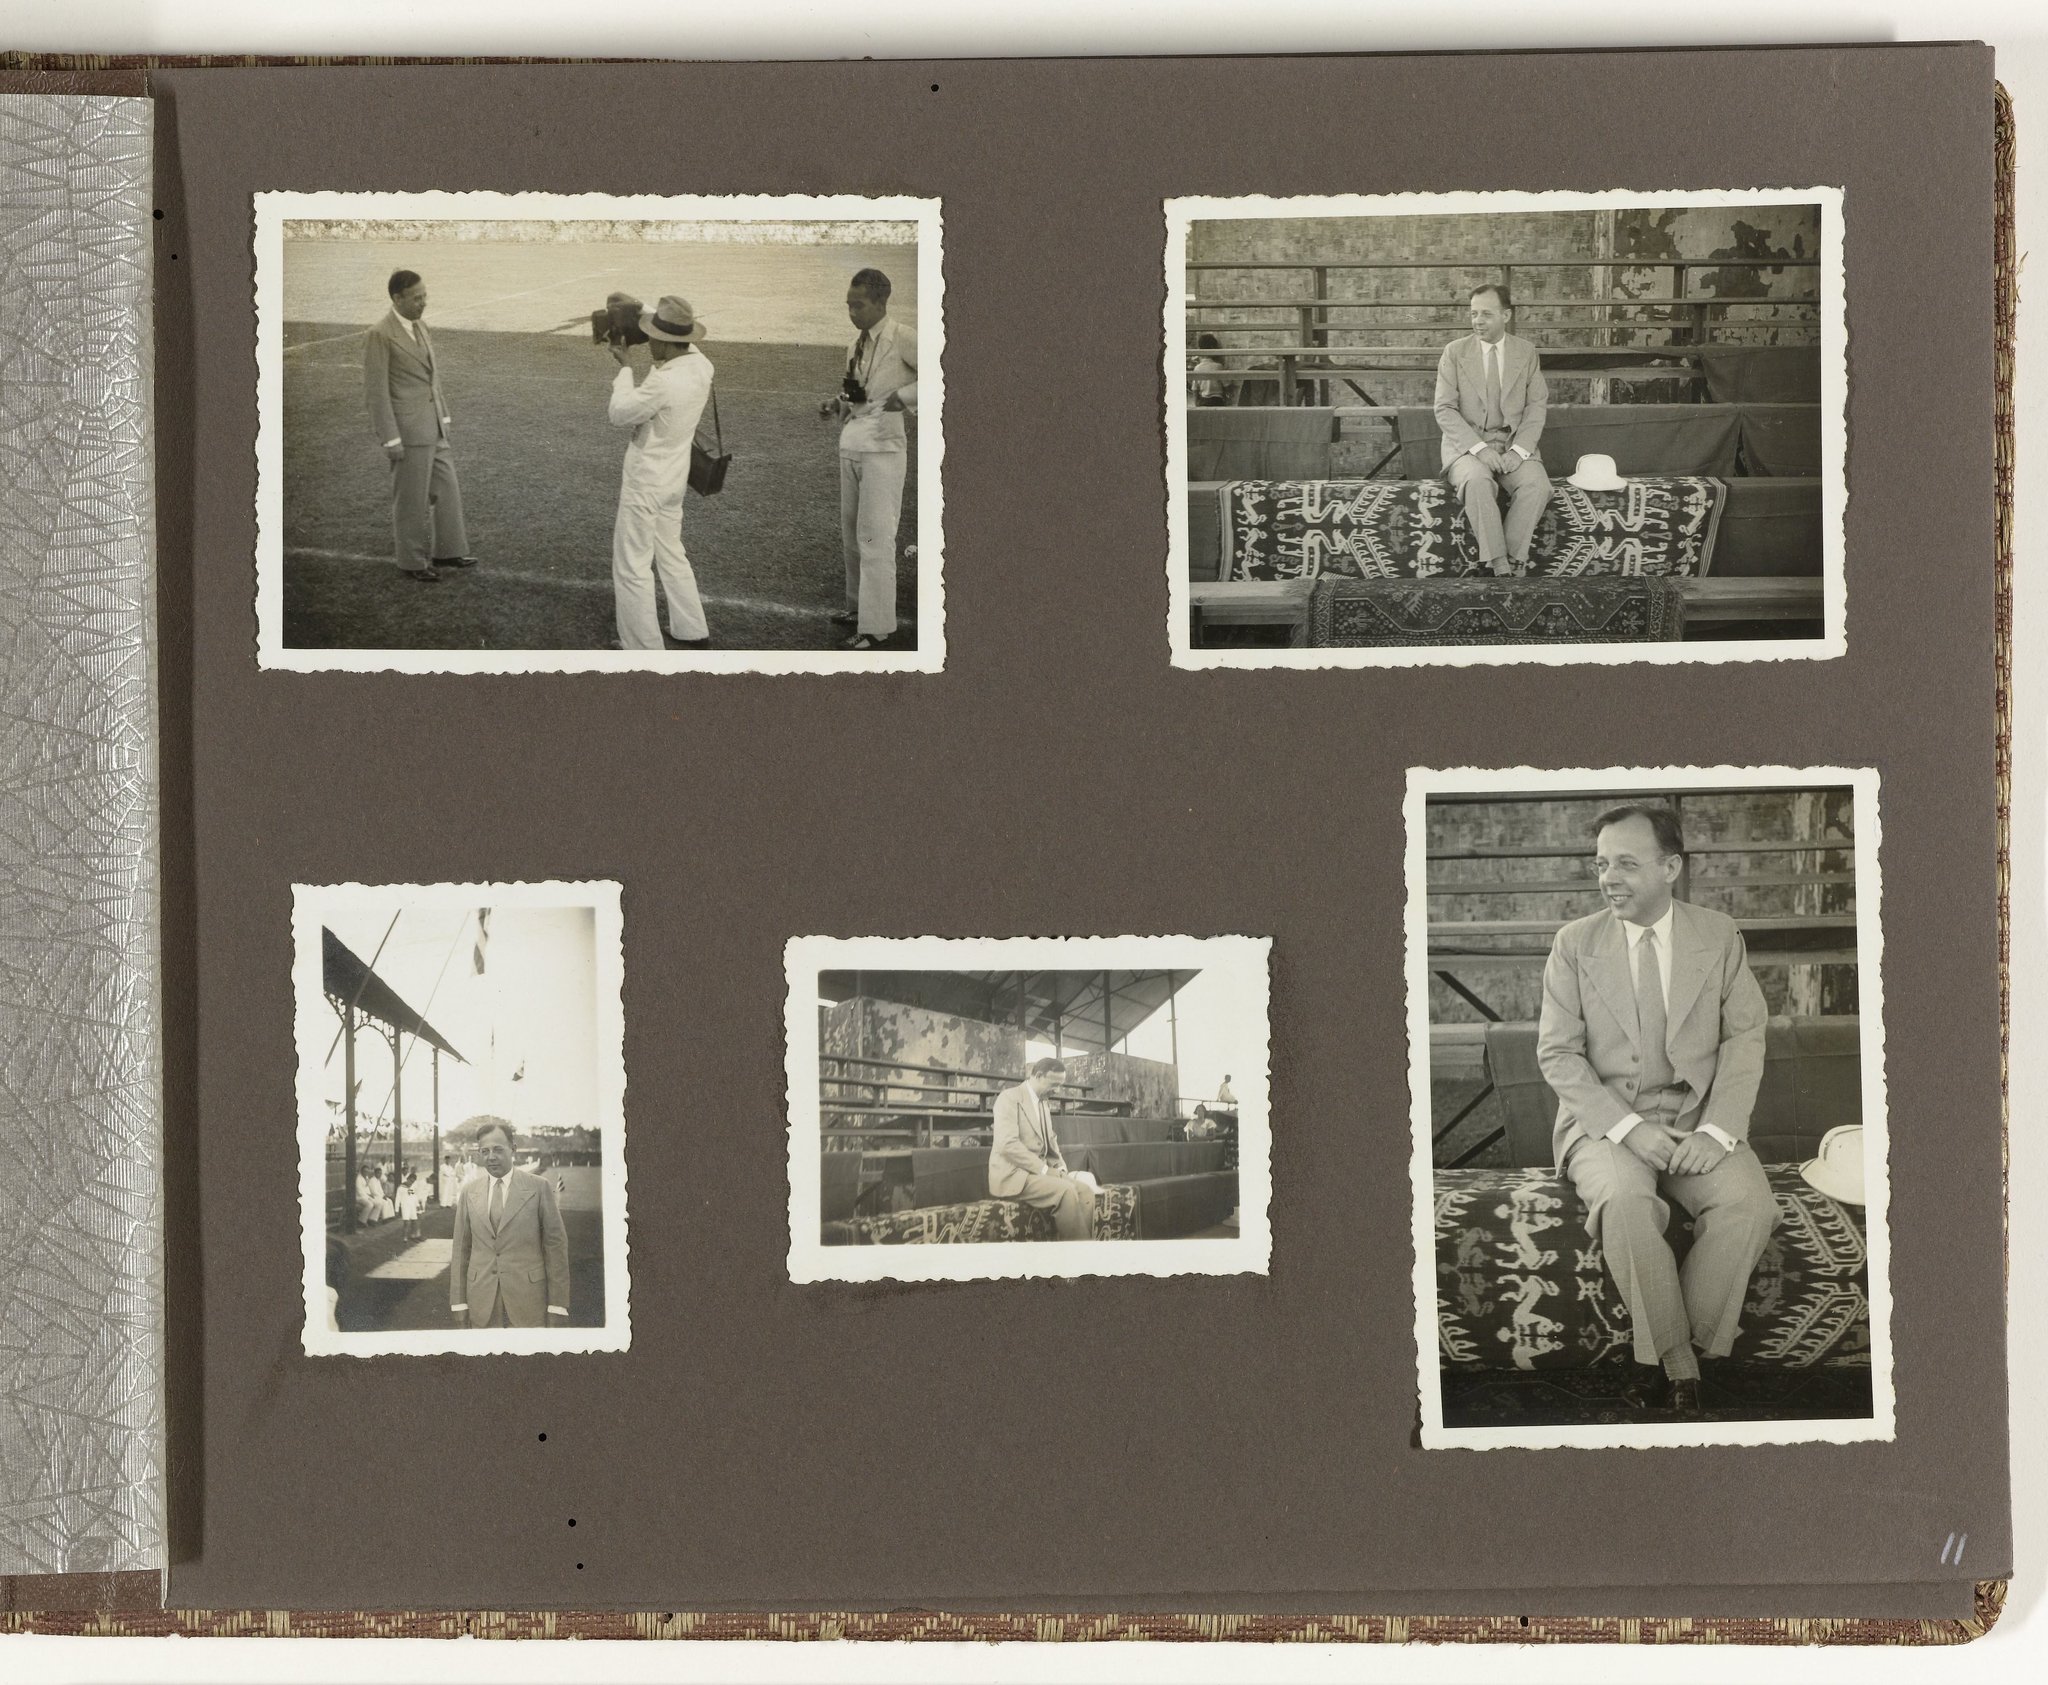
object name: photograph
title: De heer Hart op de tribune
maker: Anonymous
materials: photographic support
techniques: gelatin silver print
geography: batavia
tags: leiden, algebra and statistics, historical persons, soccer, football (early names: soule, choule, cholle) (+ public (sports, games, etc.)), colonial government, batavia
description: In 1920 werd door de Directeur van Landbouw, Nijverheid en Handel een begin gemaakt met bundeling van statischtische werkzaamheden in één Statistisch Kantoor. In 1924 werd dit kantoor samengevoegd met statistiek van in- en uitvoer in het 'Centraal kantoor voor de Statistiek', gevestigd in Weltevreden, met prof. dr. J. van Gelderen als eerste directeur.